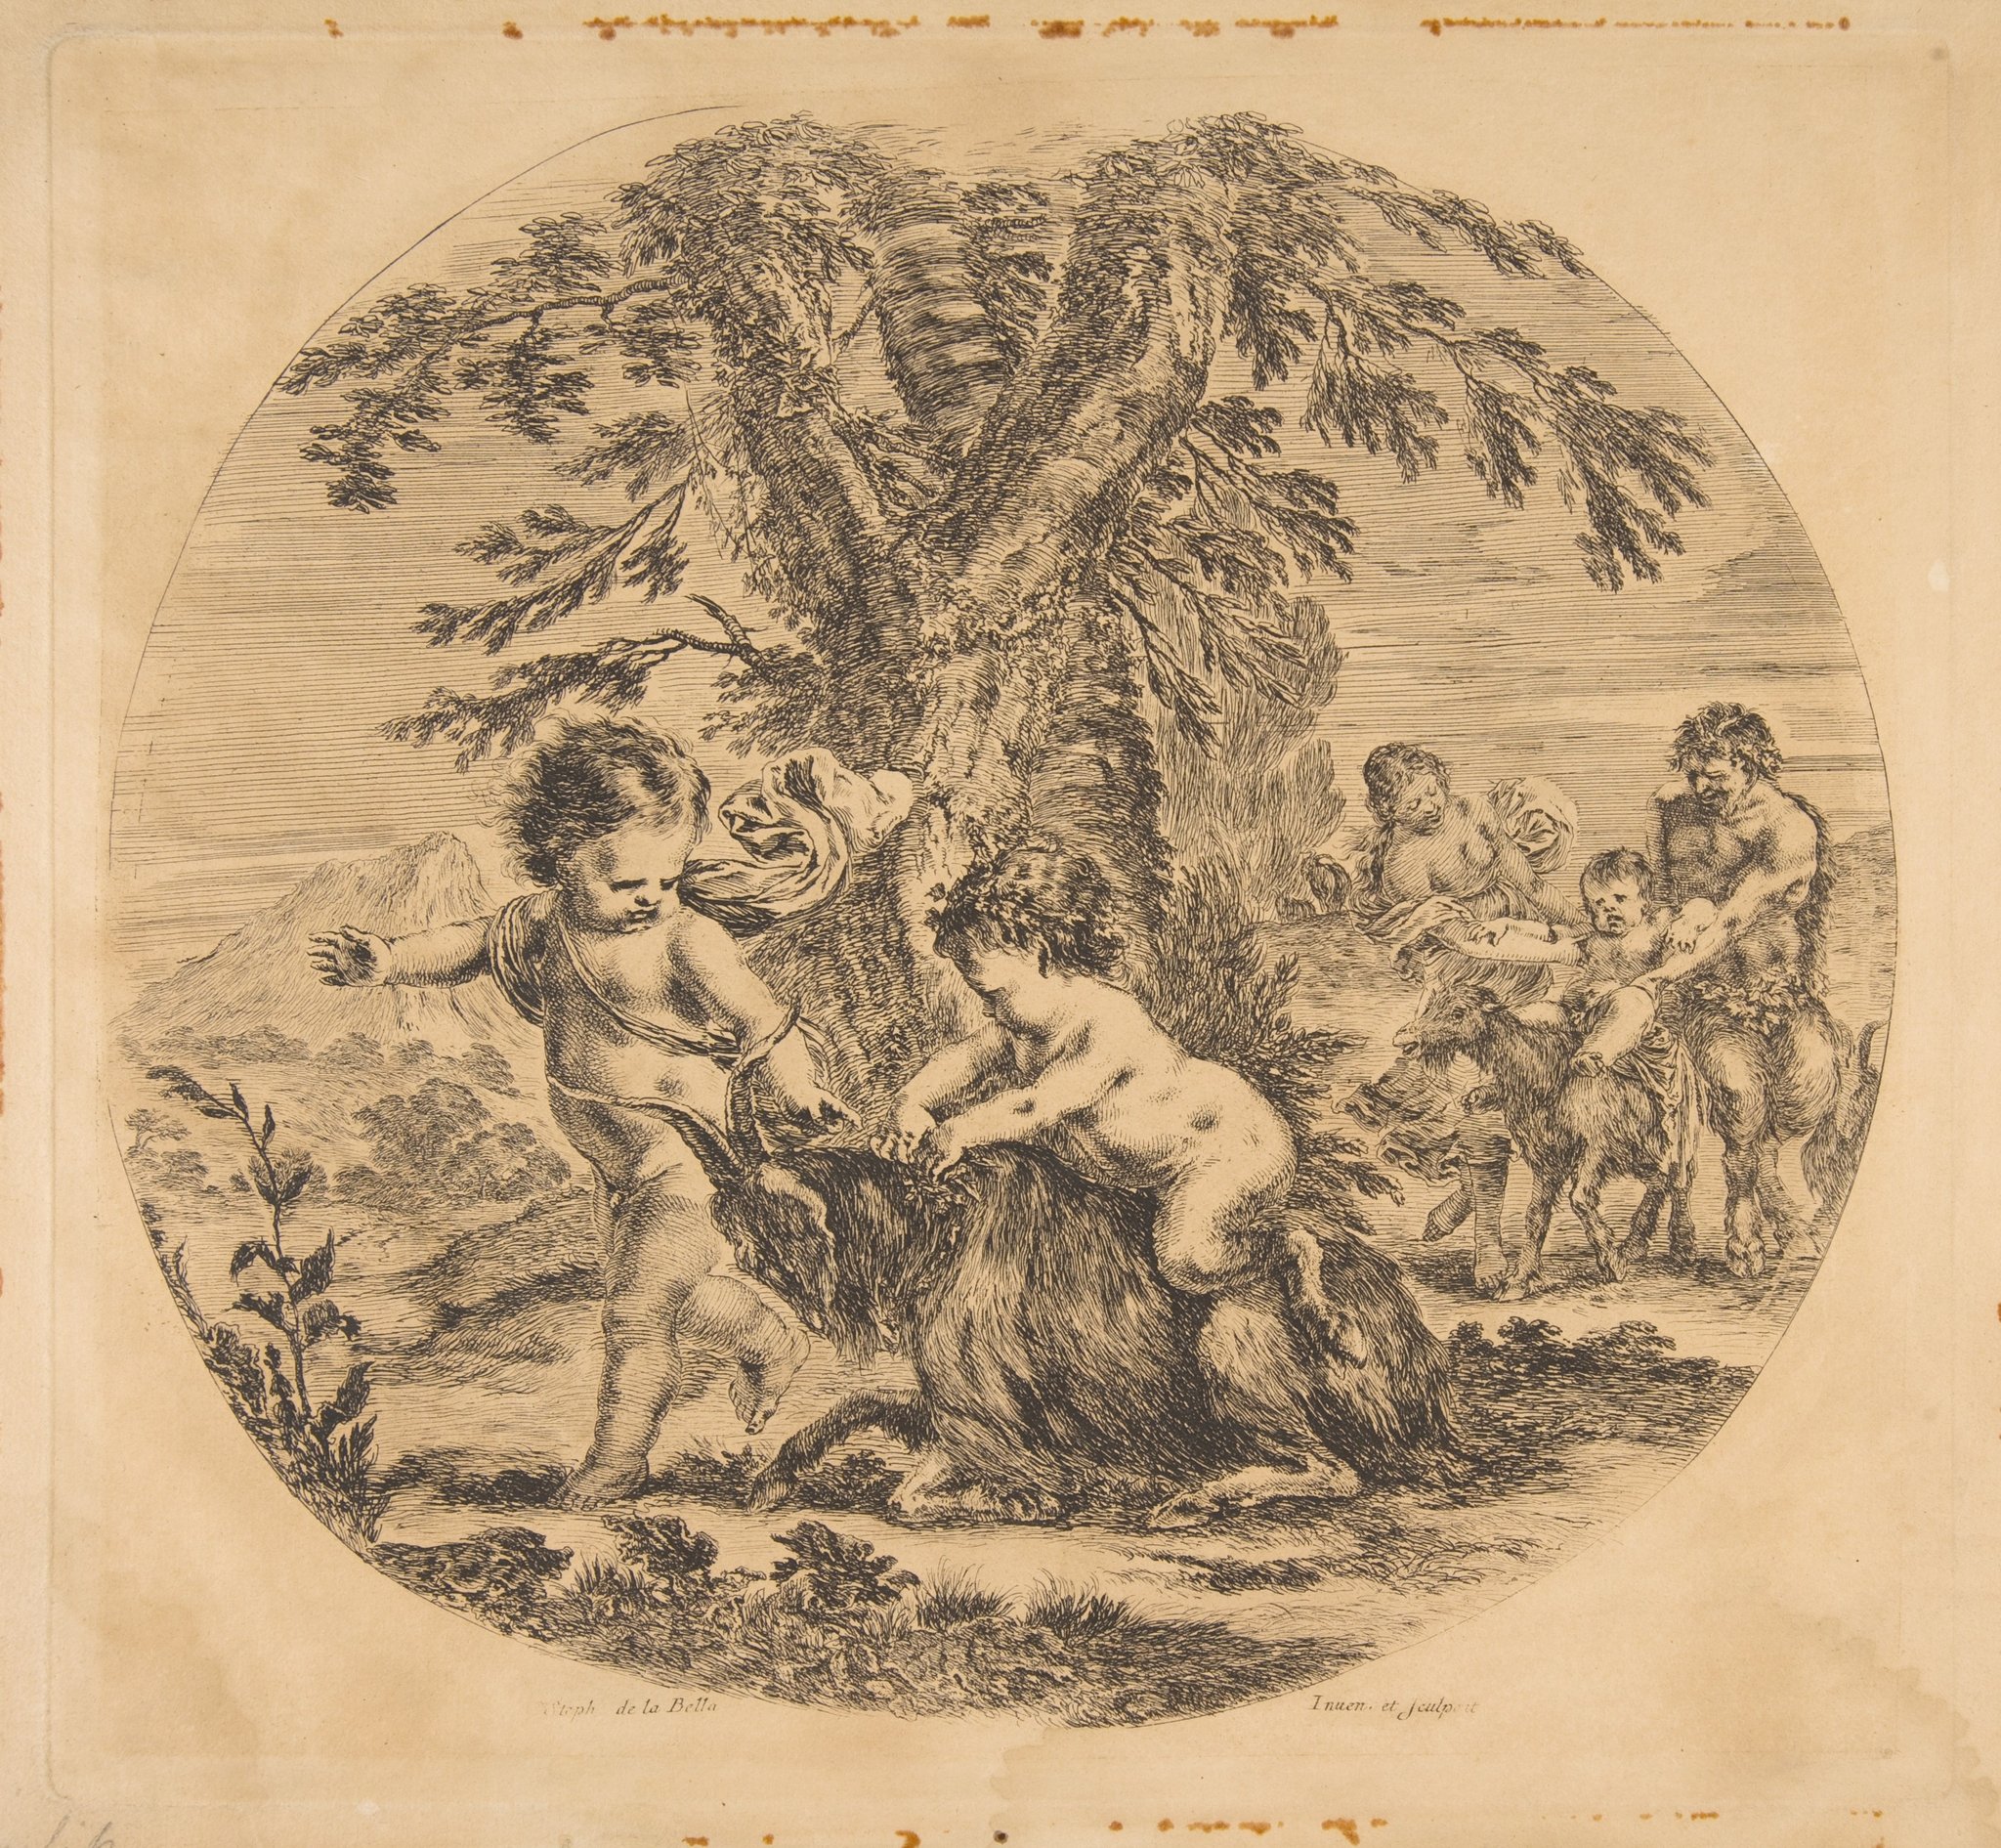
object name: print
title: A child and a satyr child playing with a goat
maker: stefano della bella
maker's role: artist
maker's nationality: italian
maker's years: 1610-1664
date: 1657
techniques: etching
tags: children,playing,satyrs,goats